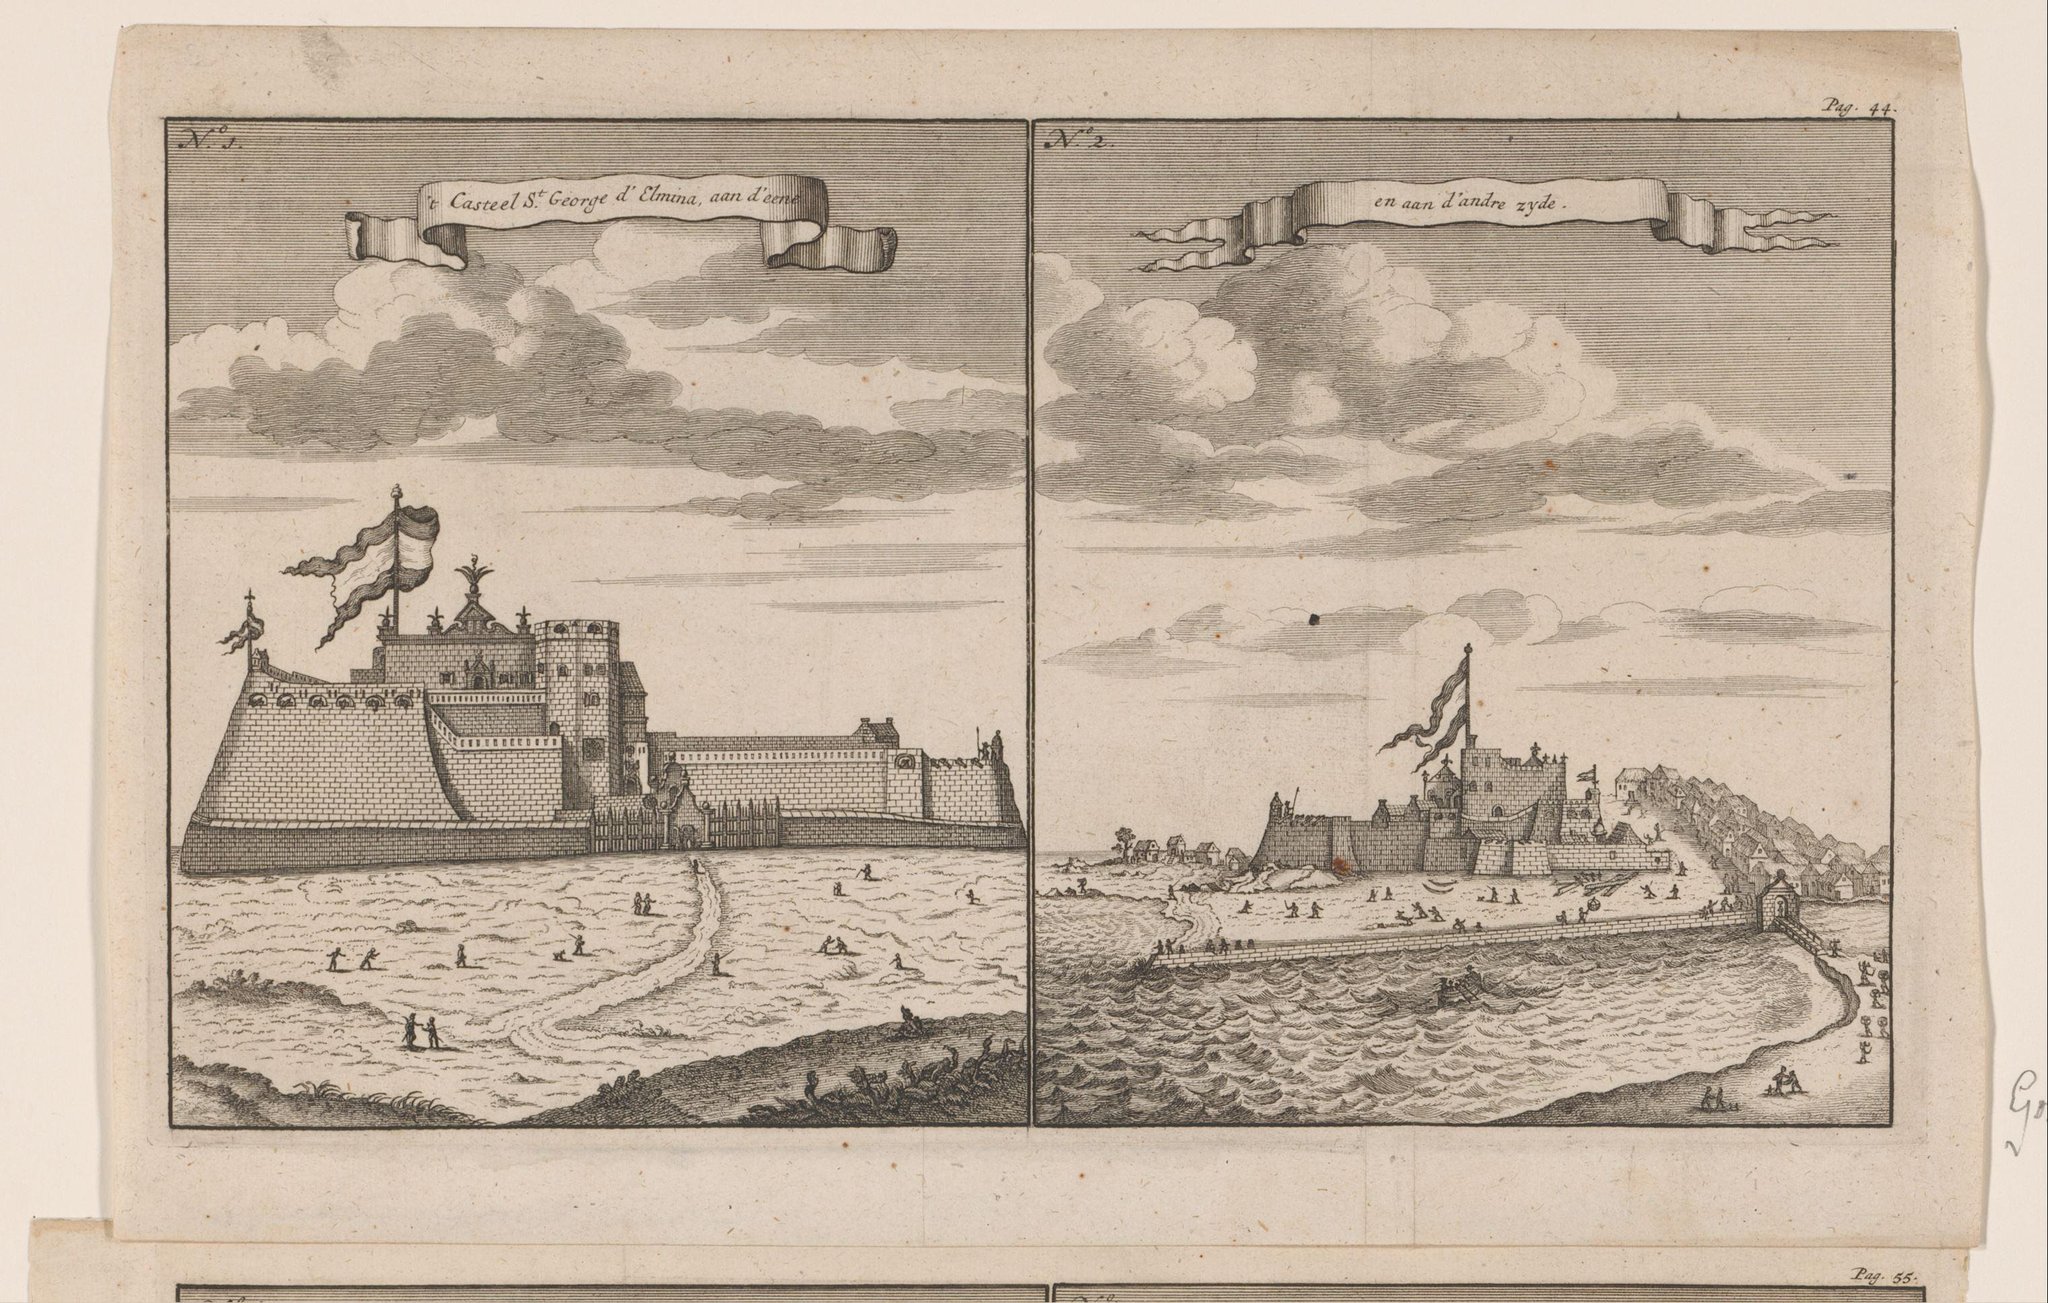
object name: book illustration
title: 't Casteel St. George d'Elmina, aan d'eene / en aan d'andre zyde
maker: Anonymous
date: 1704-1737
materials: paper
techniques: etching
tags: fortress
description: Prent gebruikt in Willems Bosmans 'Nauwkeurige beschryving van de Guinese goud- tand- en slavekust', tussen 1704 en 1737 uitgegeven door verschillende uitgevers.